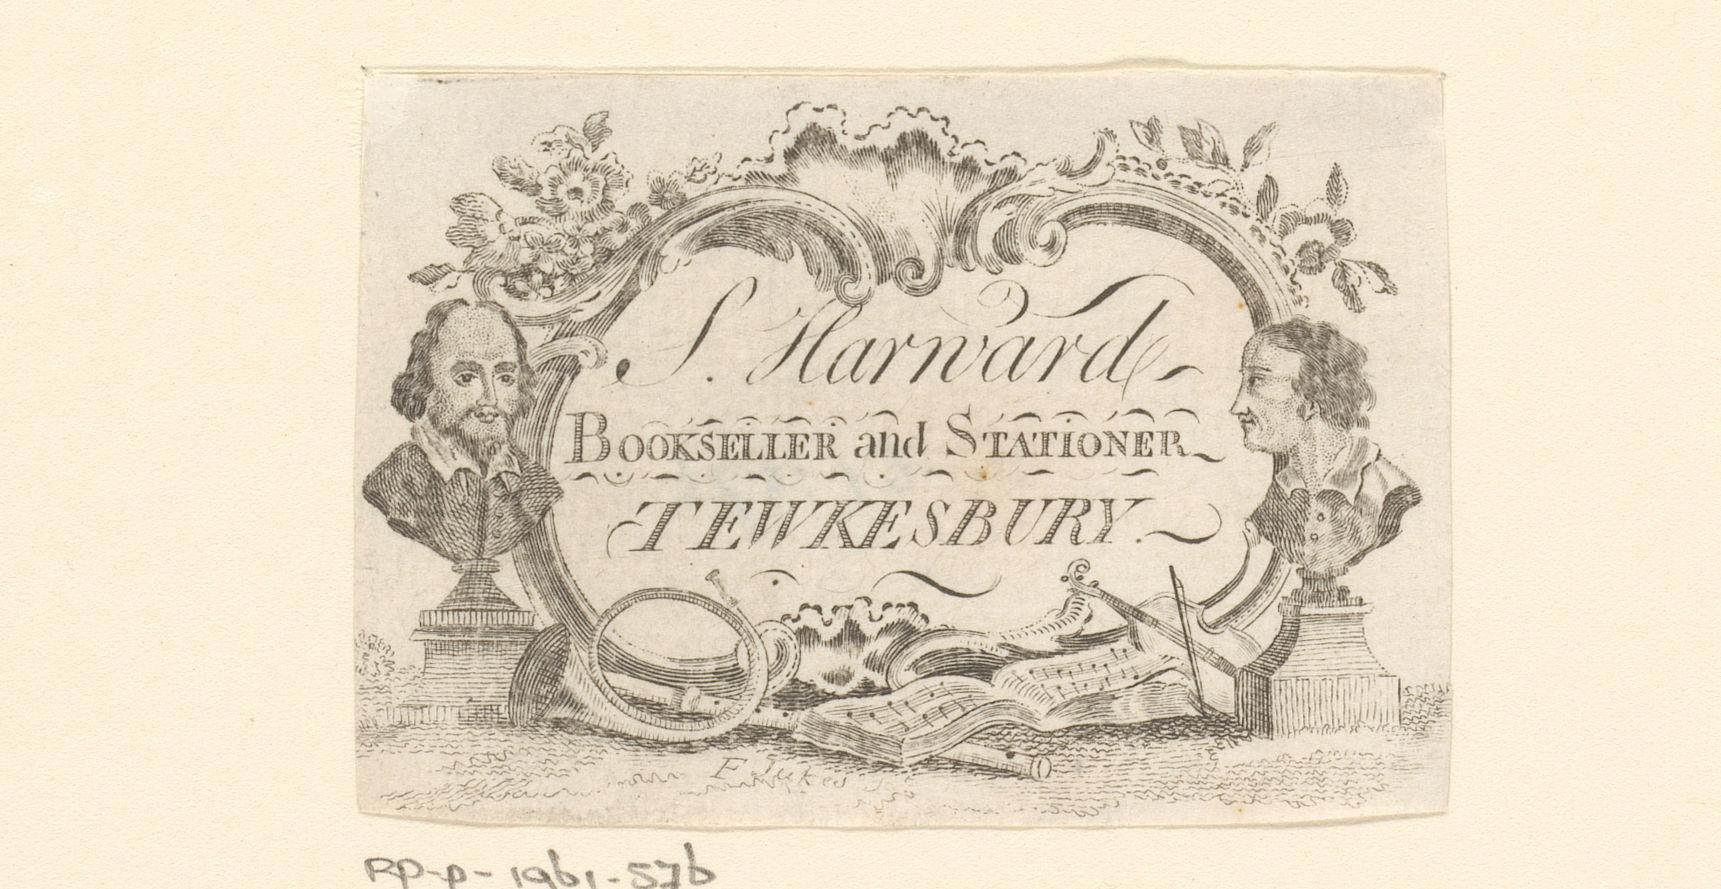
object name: business card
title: Adreskaart van boekhandelaar S. Harward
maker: francis jukes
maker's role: print maker, publisher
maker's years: 1745-1812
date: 1755-1812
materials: paper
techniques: engraving, etching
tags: horn, trumpet, cornet, trombone, tuba, violin, fiddle, portrait of a writer, piece of sculpture, reproduction of a piece of sculpture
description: Een decoratieve lijst met links een buste van Shakespeare en rechts een tweede buste. Voor de lijst liggen muziekinstrumenten en een muziekboek. In de lijst de tekst: 'S. Harward Bookseller and Stationer Tewkesbury'.